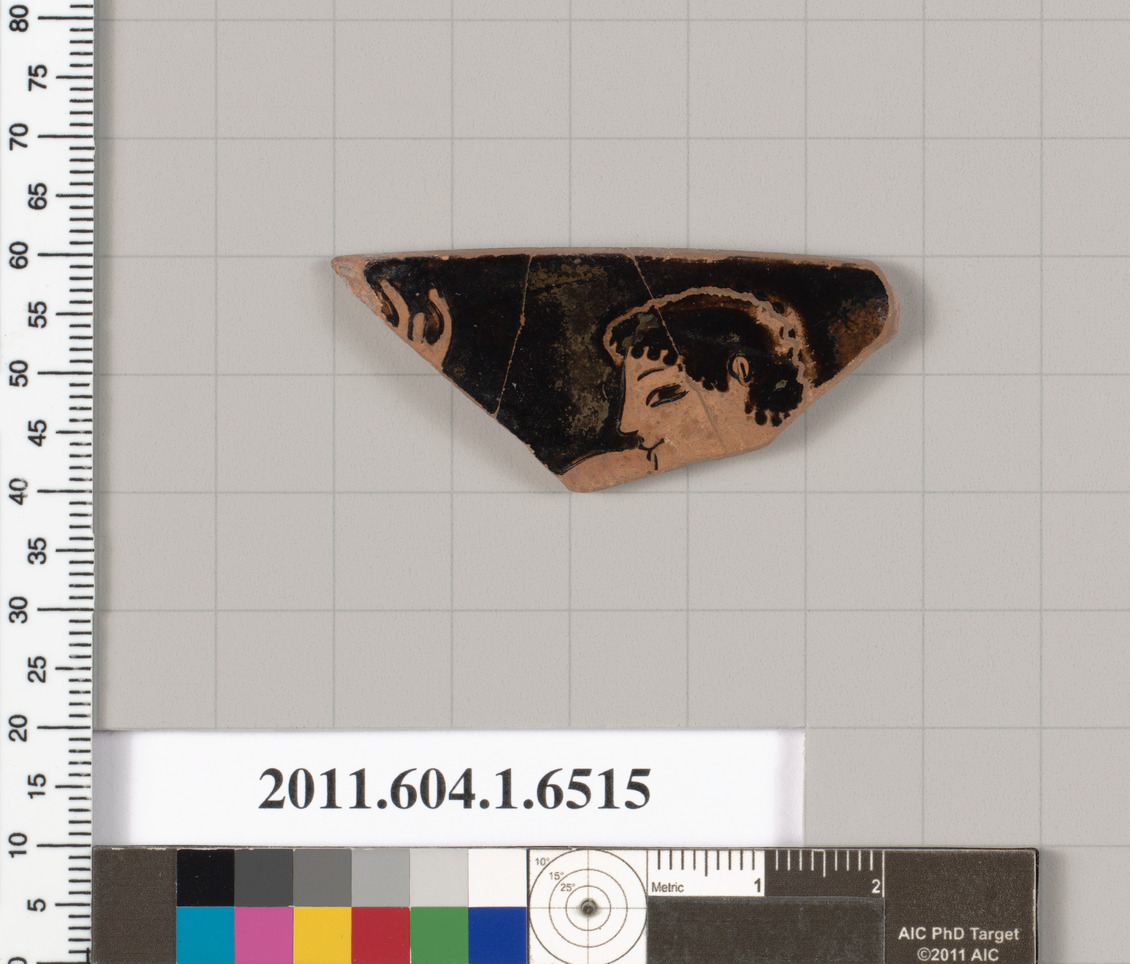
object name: kylix fragment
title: Terracotta rim fragment of a kylix (drinking cup)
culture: greek, attic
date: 490-480 BCE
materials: terracotta